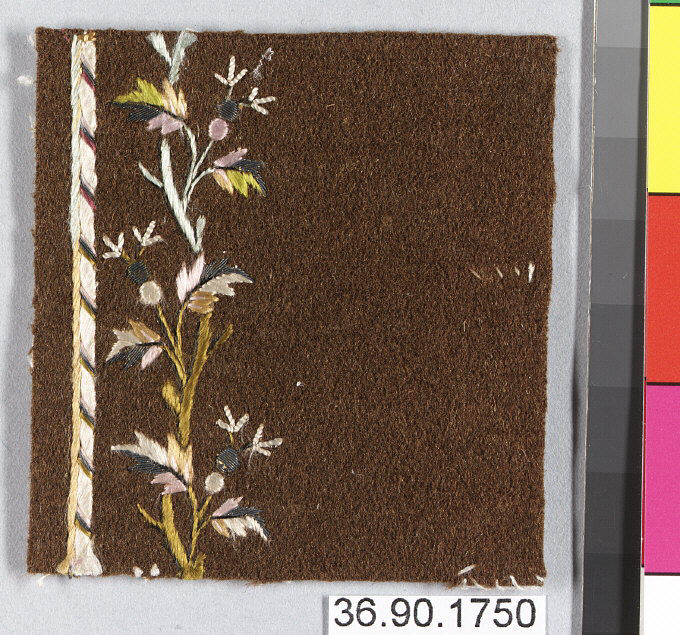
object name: sample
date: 1801-1833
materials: felt, metal thread, silk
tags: plants